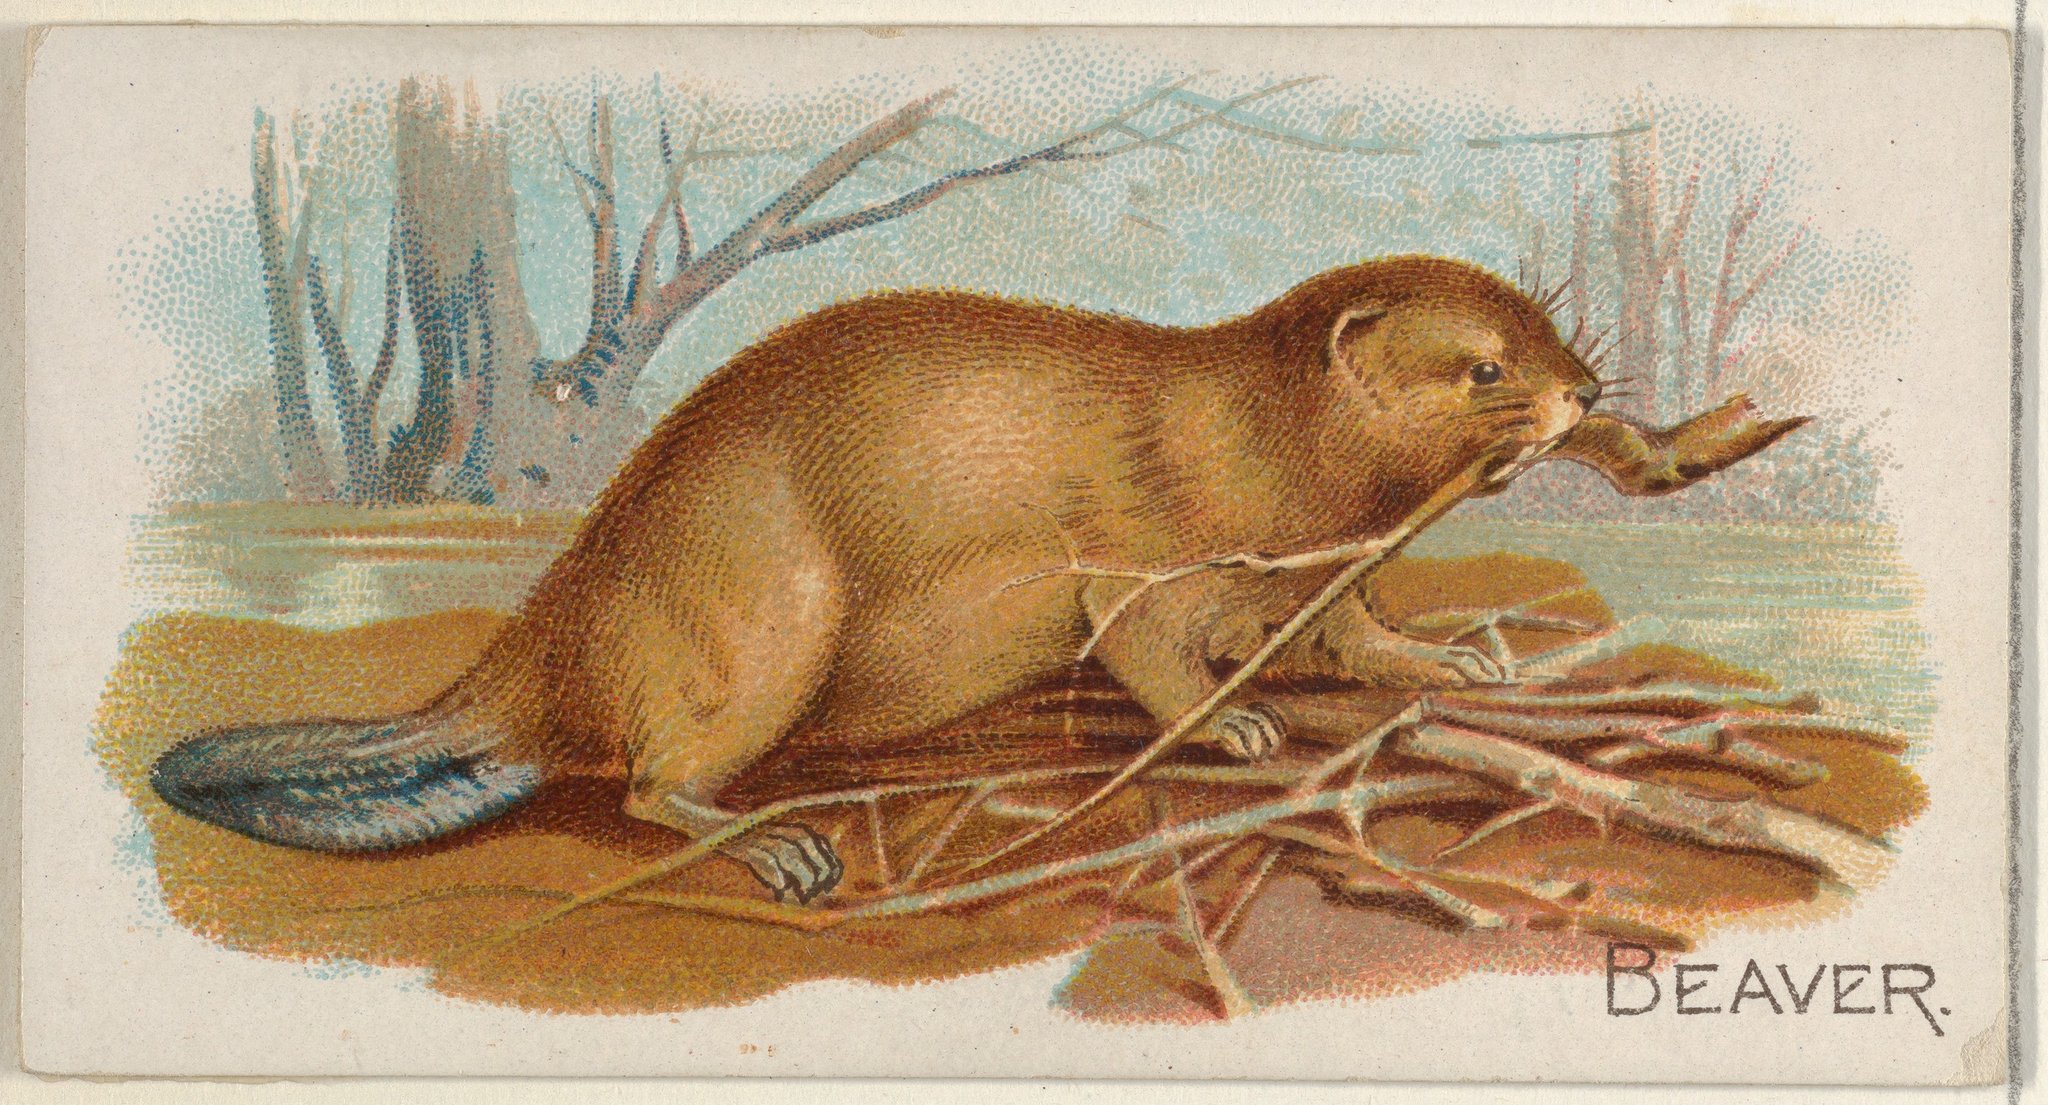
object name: print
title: Beaver, from the Quadrupeds series (N21) for Allen & Ginter Cigarettes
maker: allen & ginter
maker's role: publisher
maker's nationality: american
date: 1890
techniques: color lithograph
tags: animals